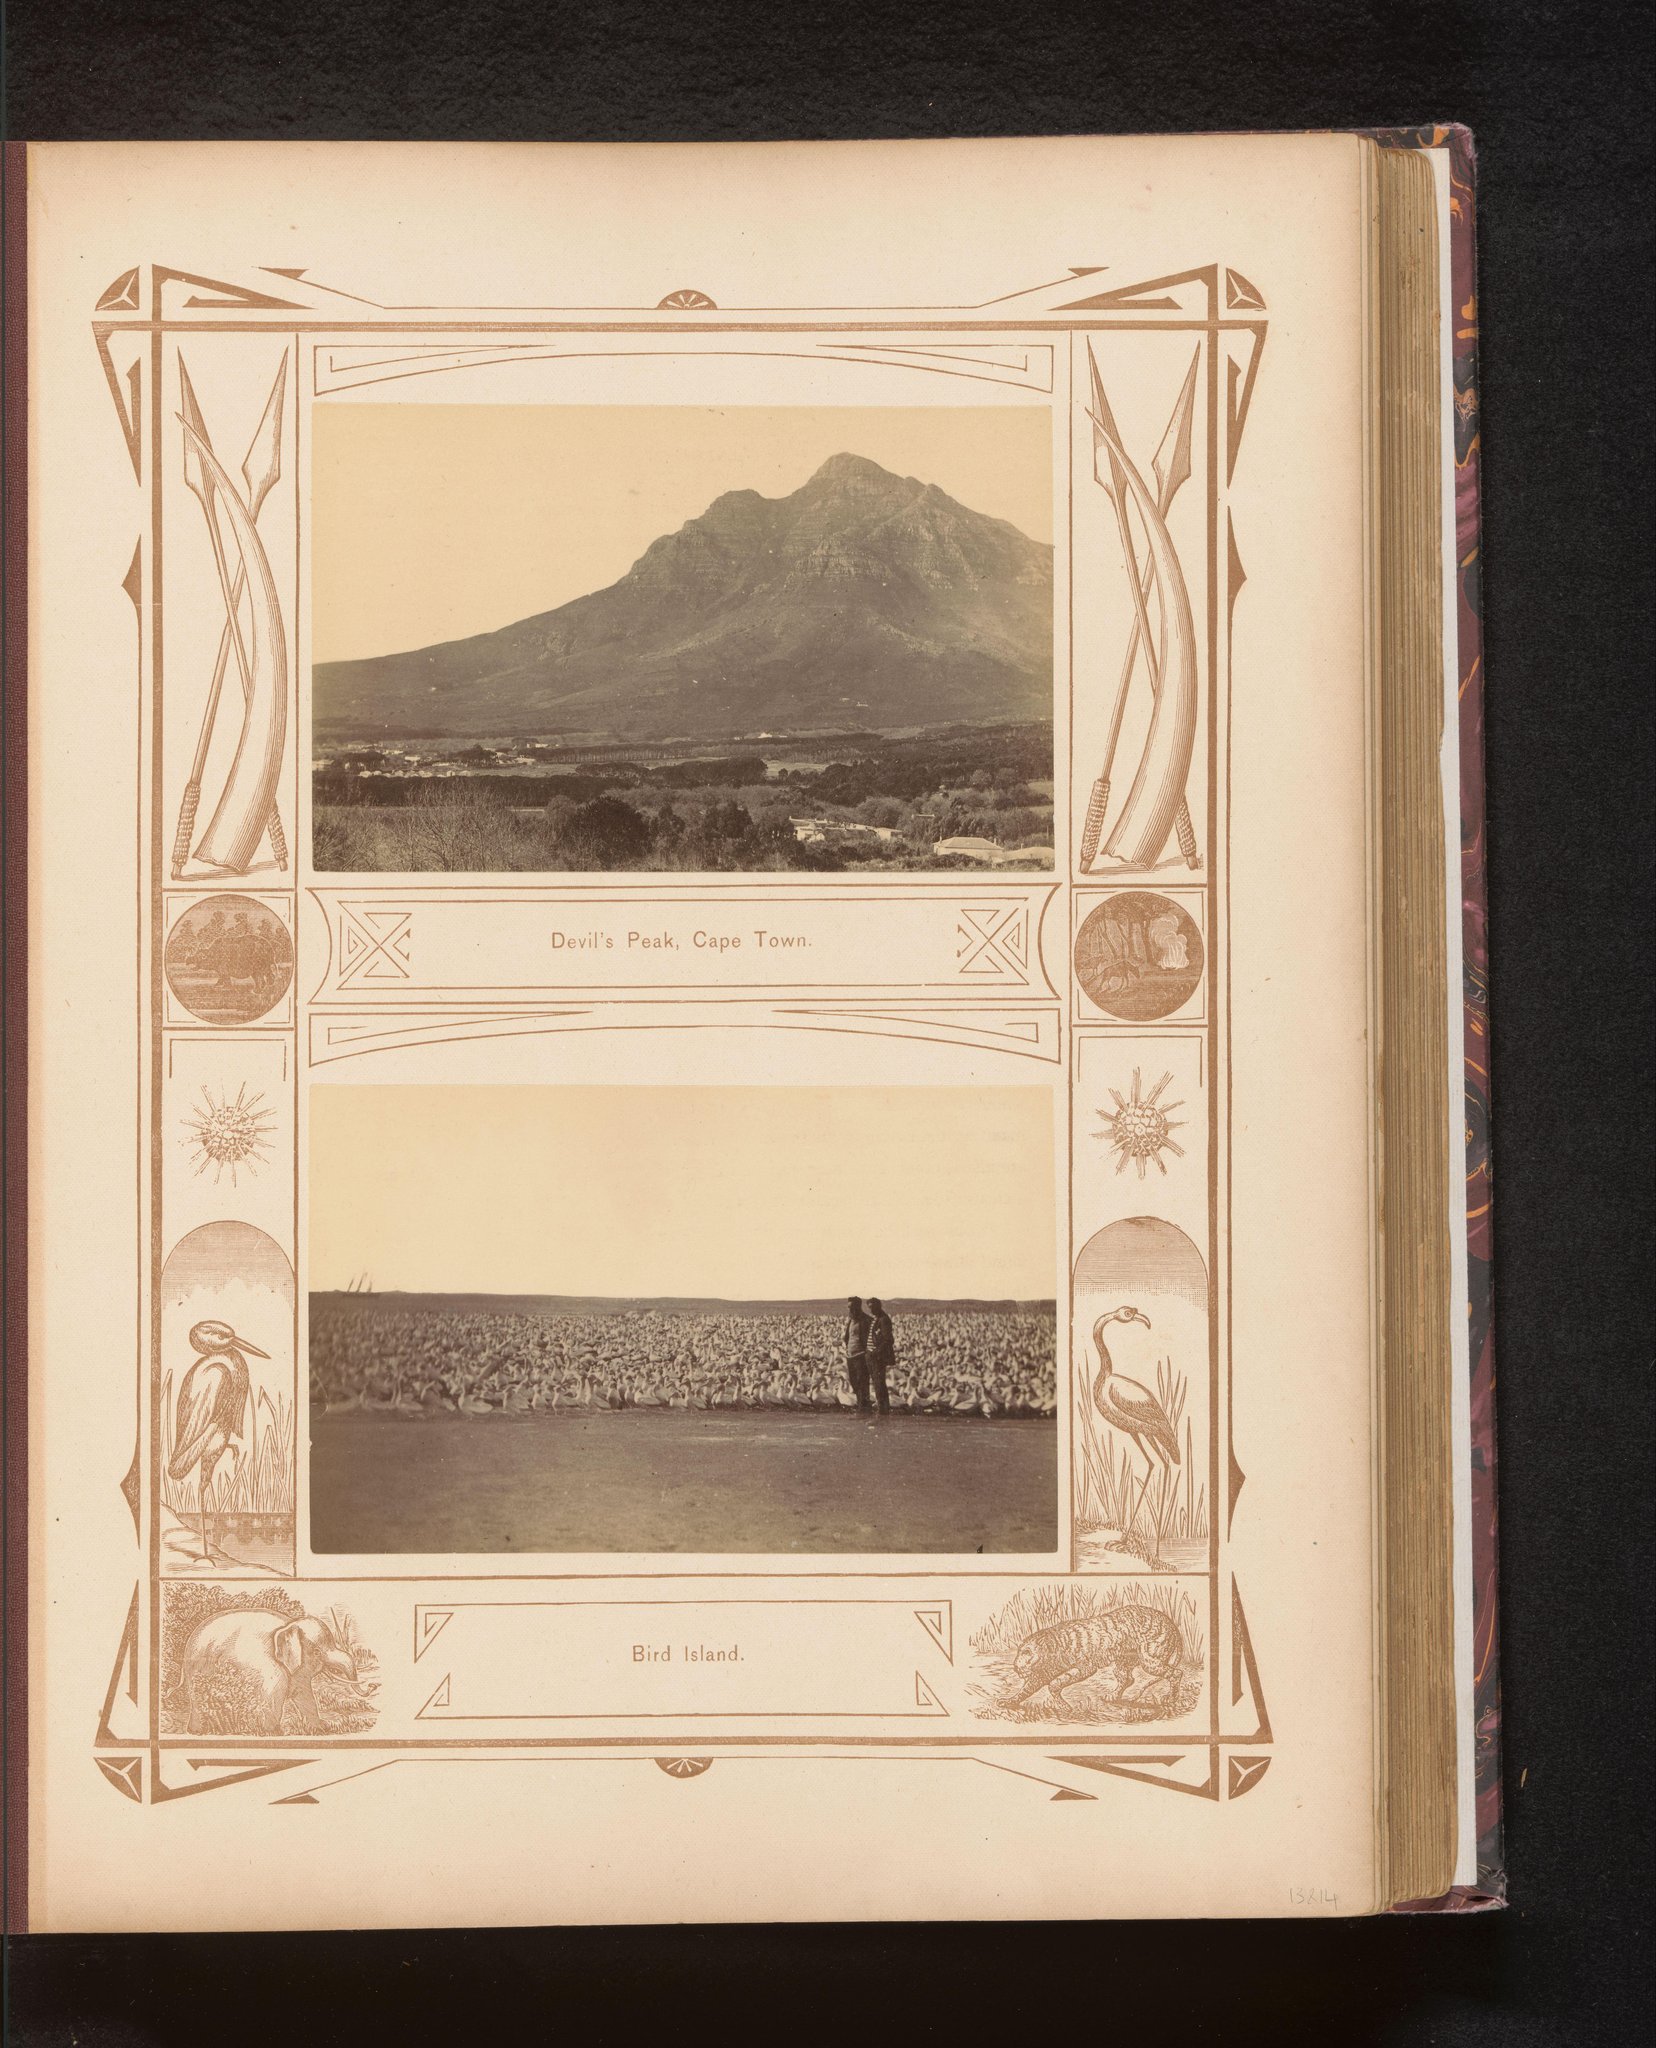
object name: page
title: Devil's Peak, Cape Town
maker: Anonymous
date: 1877-1882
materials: photographic support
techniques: albumen print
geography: duivelspiek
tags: landscapes, mountains